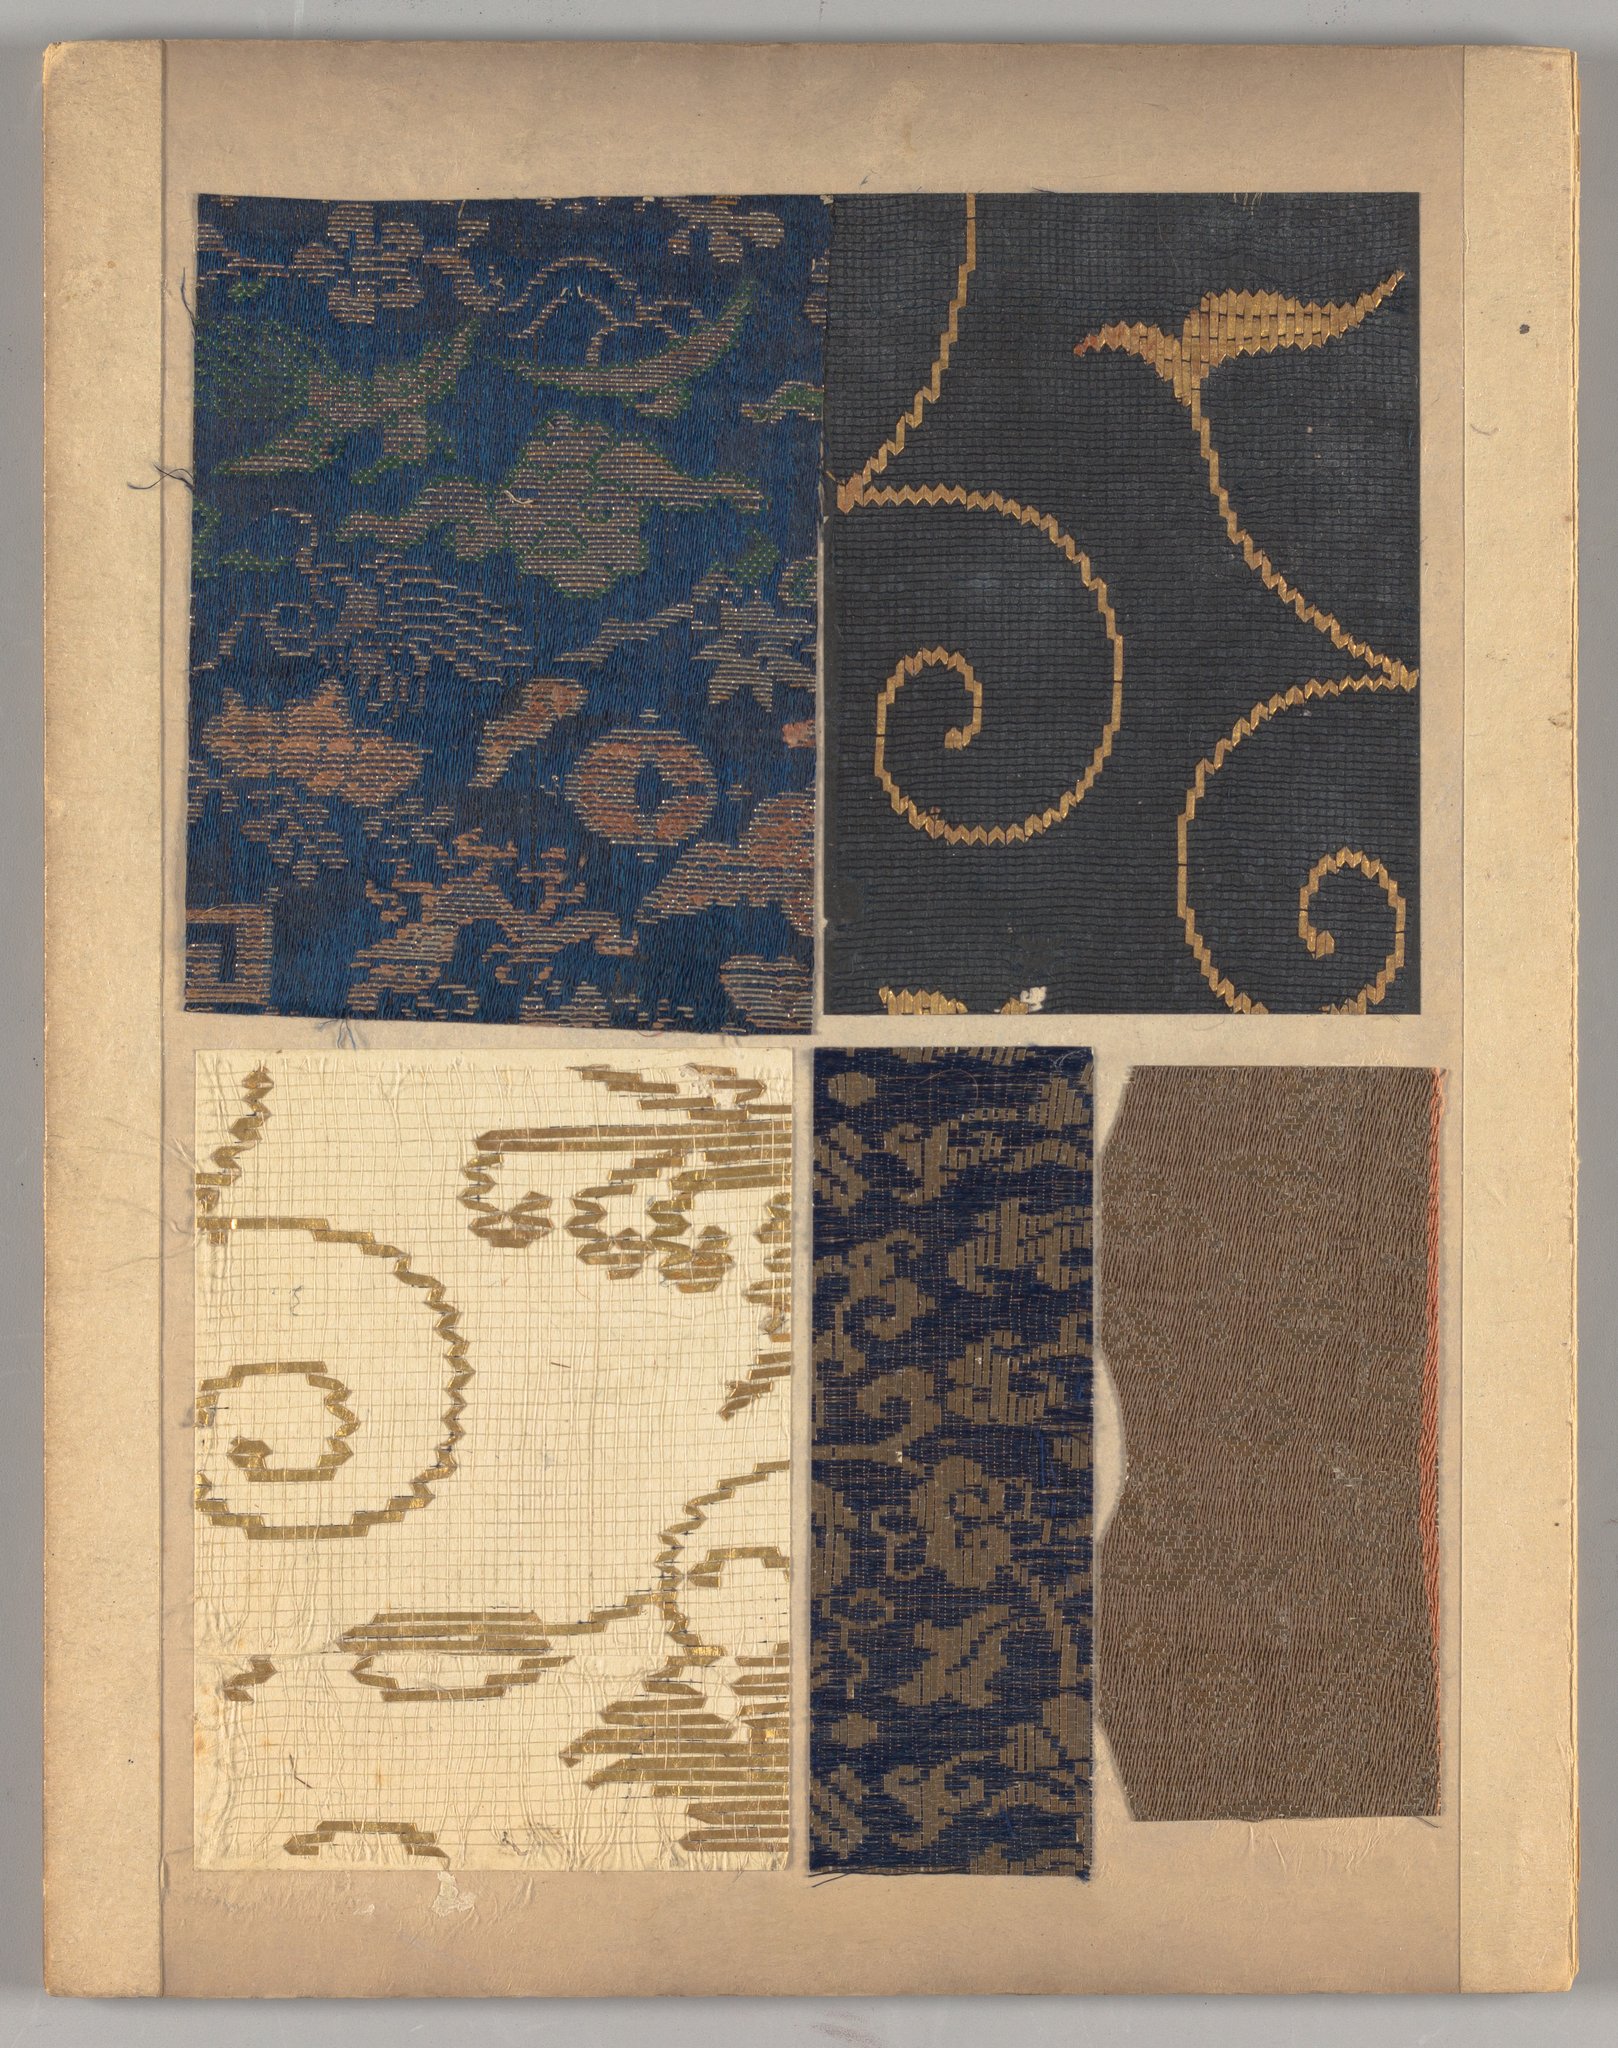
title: [Japanese textiles]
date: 1920-1929